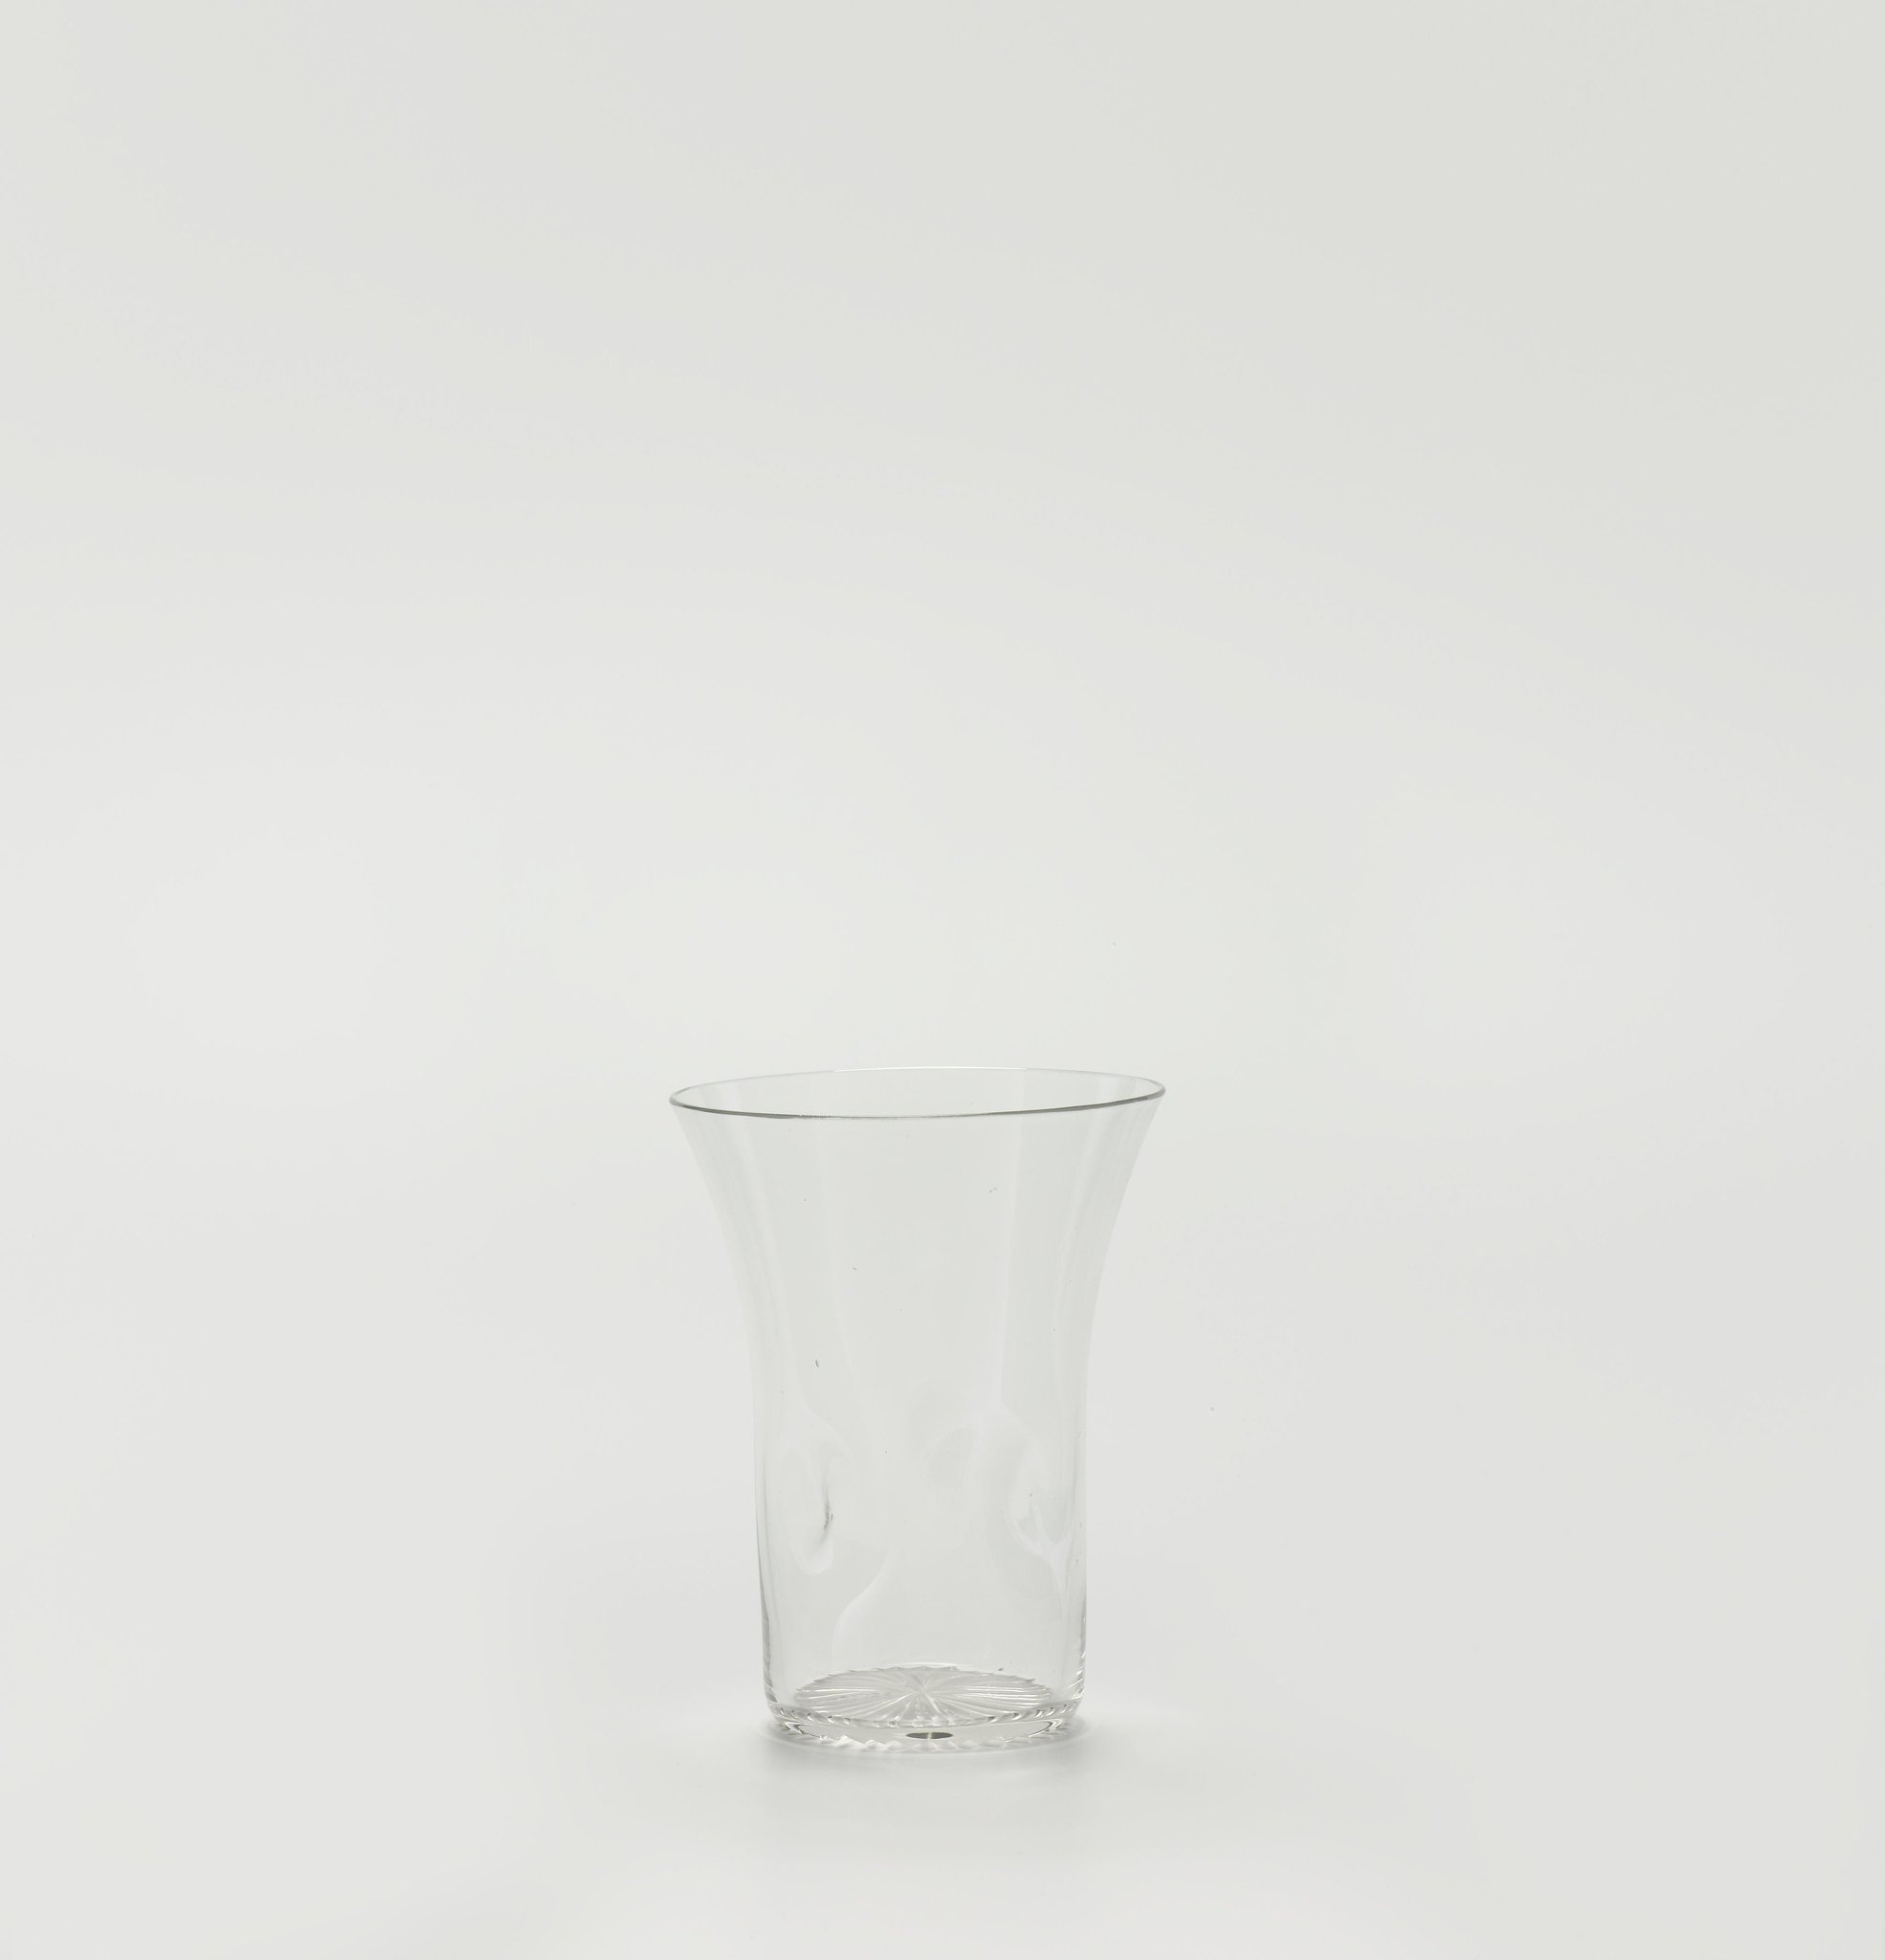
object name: cup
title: Beker met instulpingen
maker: gerard muller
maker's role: draughtsman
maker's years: 1861-1929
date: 1900-1925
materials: glass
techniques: glassblowing, grinding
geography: amsterdam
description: Vlakke bodem met ingeslepen ster, conisch, naar boven uitlopend lichaam, op drie plaatsen ingestulpt.